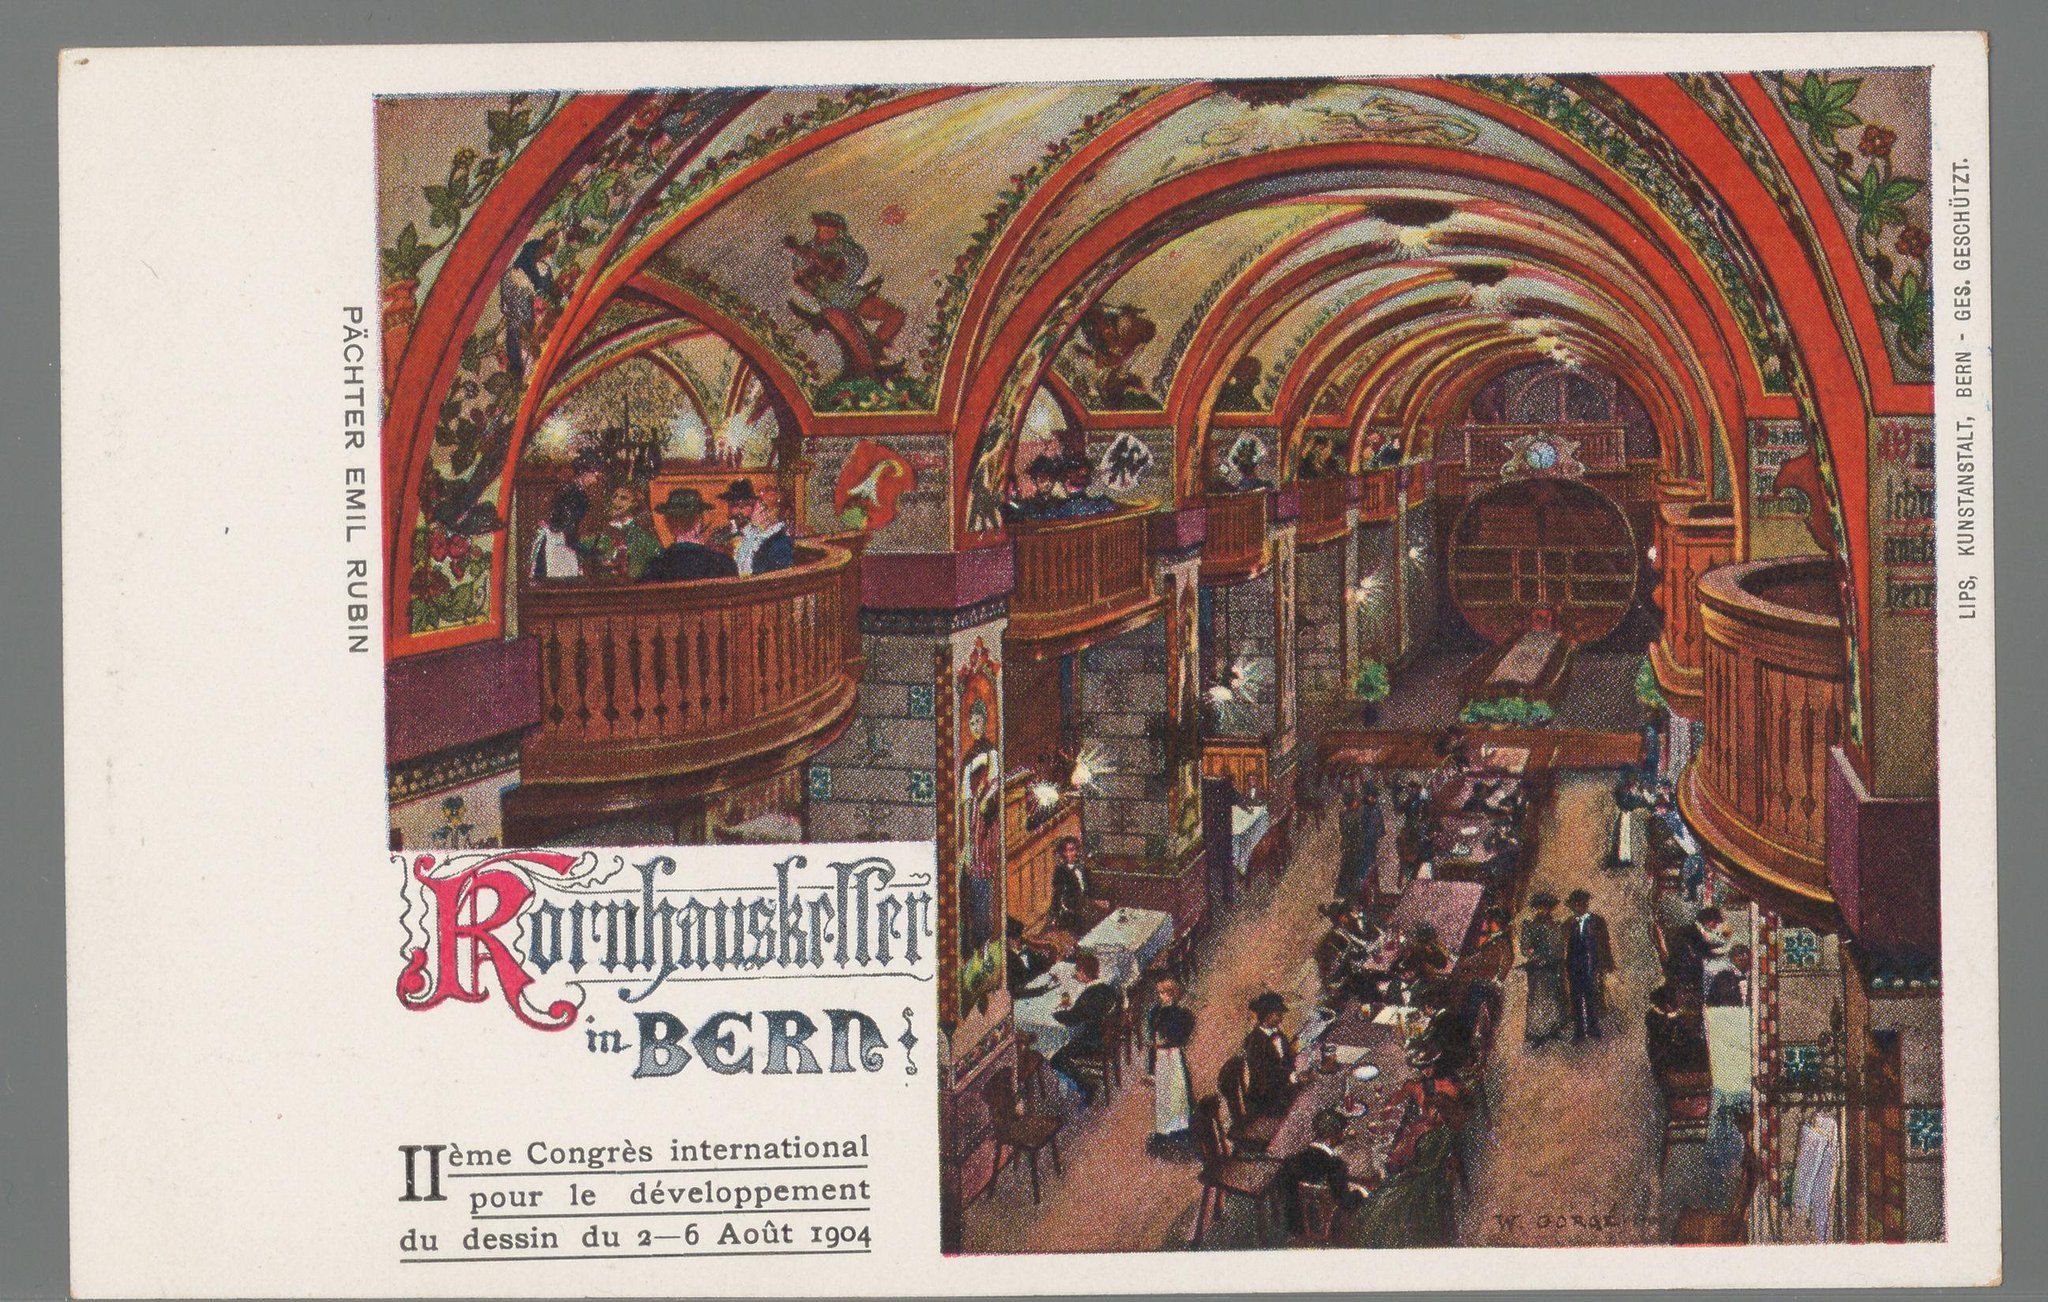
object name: photomechanical print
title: Kornhauskeller in Bern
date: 1903-1904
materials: cardboard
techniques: four-color autotype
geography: bern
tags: decorations (interior of the house), eating and drinking, restaurant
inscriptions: signature: ‘W. Gor[...]’